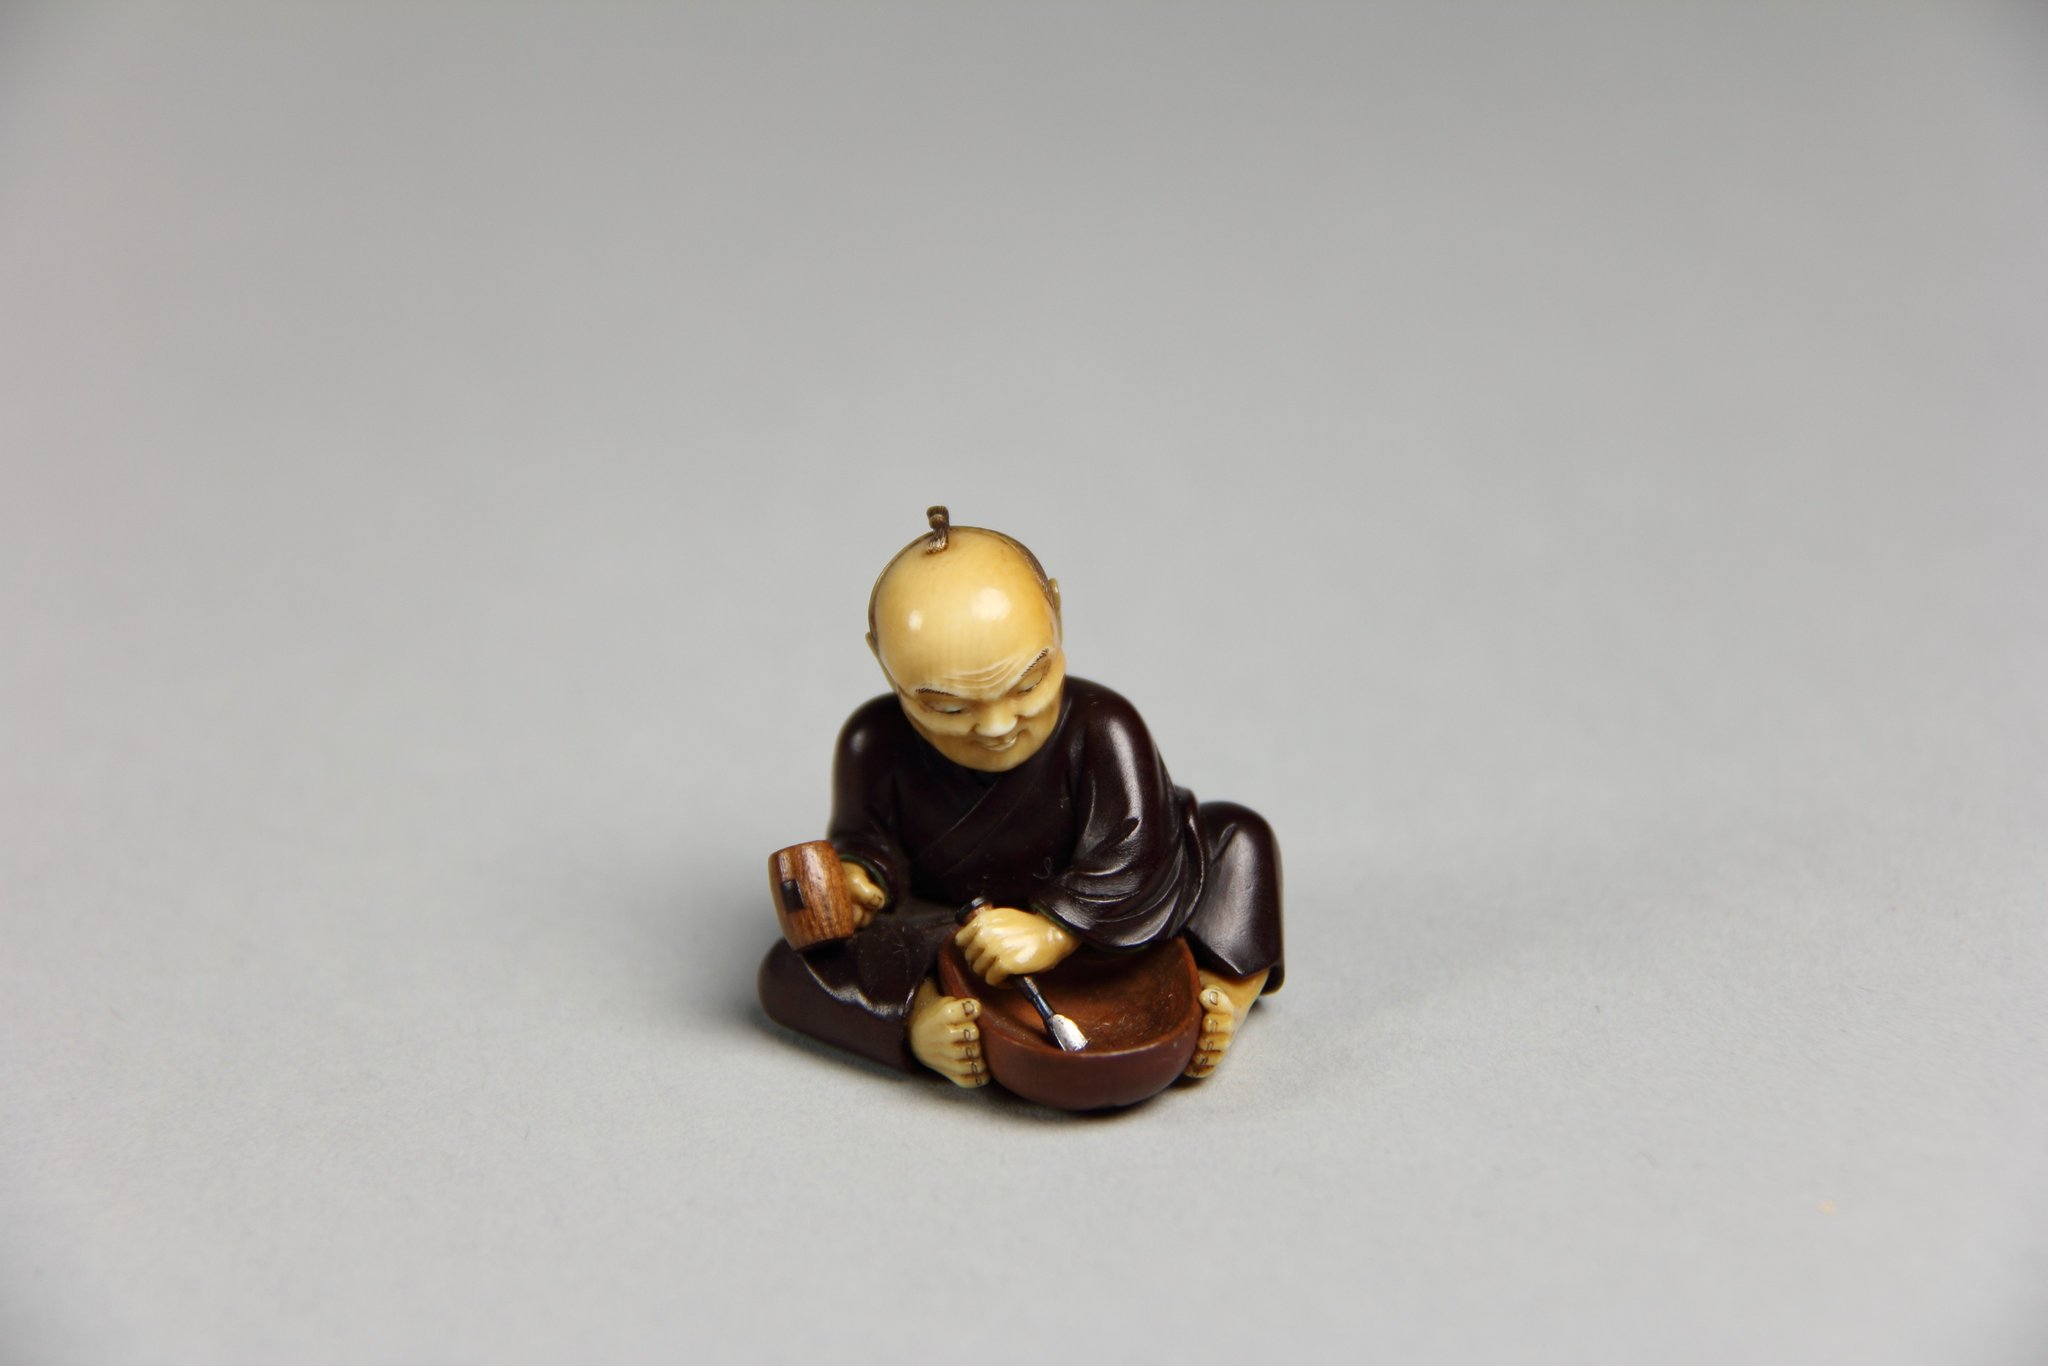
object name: netsuke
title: Netsuke of Mask Maker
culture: japanese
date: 1801-1900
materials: ivory, wood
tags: men